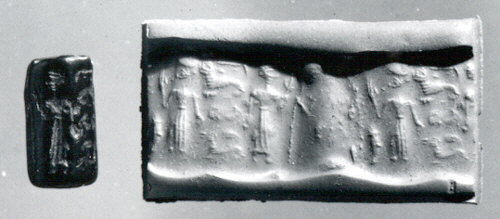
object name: cylinder seal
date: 1900-1800 BCE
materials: stone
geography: syria